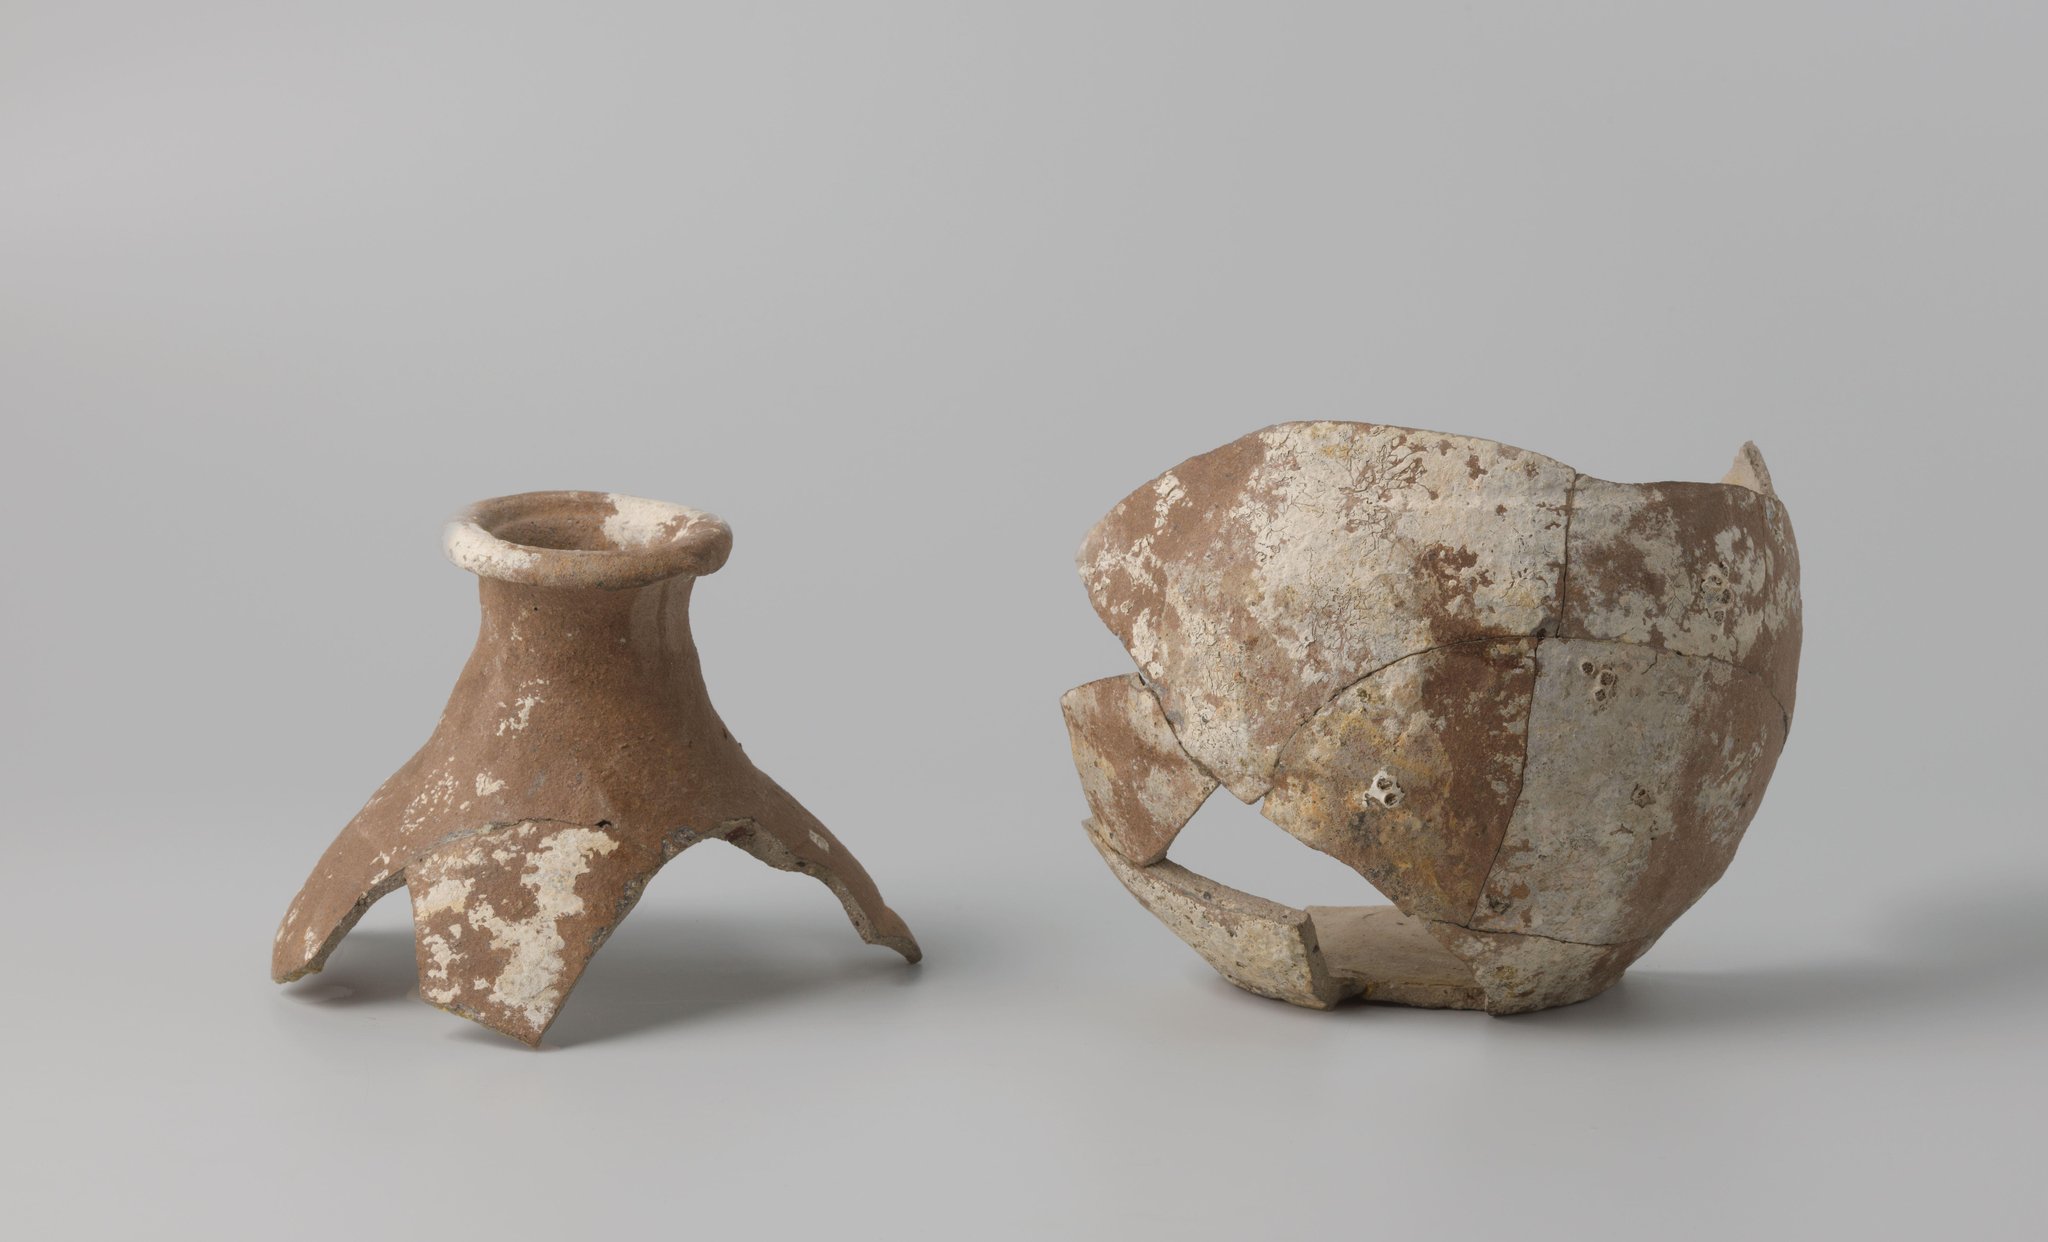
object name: martavaan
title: Scherven van een martavaan uit V.O.C.-schip de 'Witte Leeuw'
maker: Anonymous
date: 1613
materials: porcelain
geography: southeast asia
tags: verenigde oostindische compagnie, sint-helena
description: A jar. This exceptional jar has a wide waist and narrows towards the neck which ends in a narrow flaring mouth. The thin, double walled base has bursted open. The grey coloured clay contains few impurities. There are no traces of glaze on the outside or inside. It ha possibly been covered with a glaze or a slip. The upper half of the exterior has concentric grooves neatly incised from the neck to the waist.